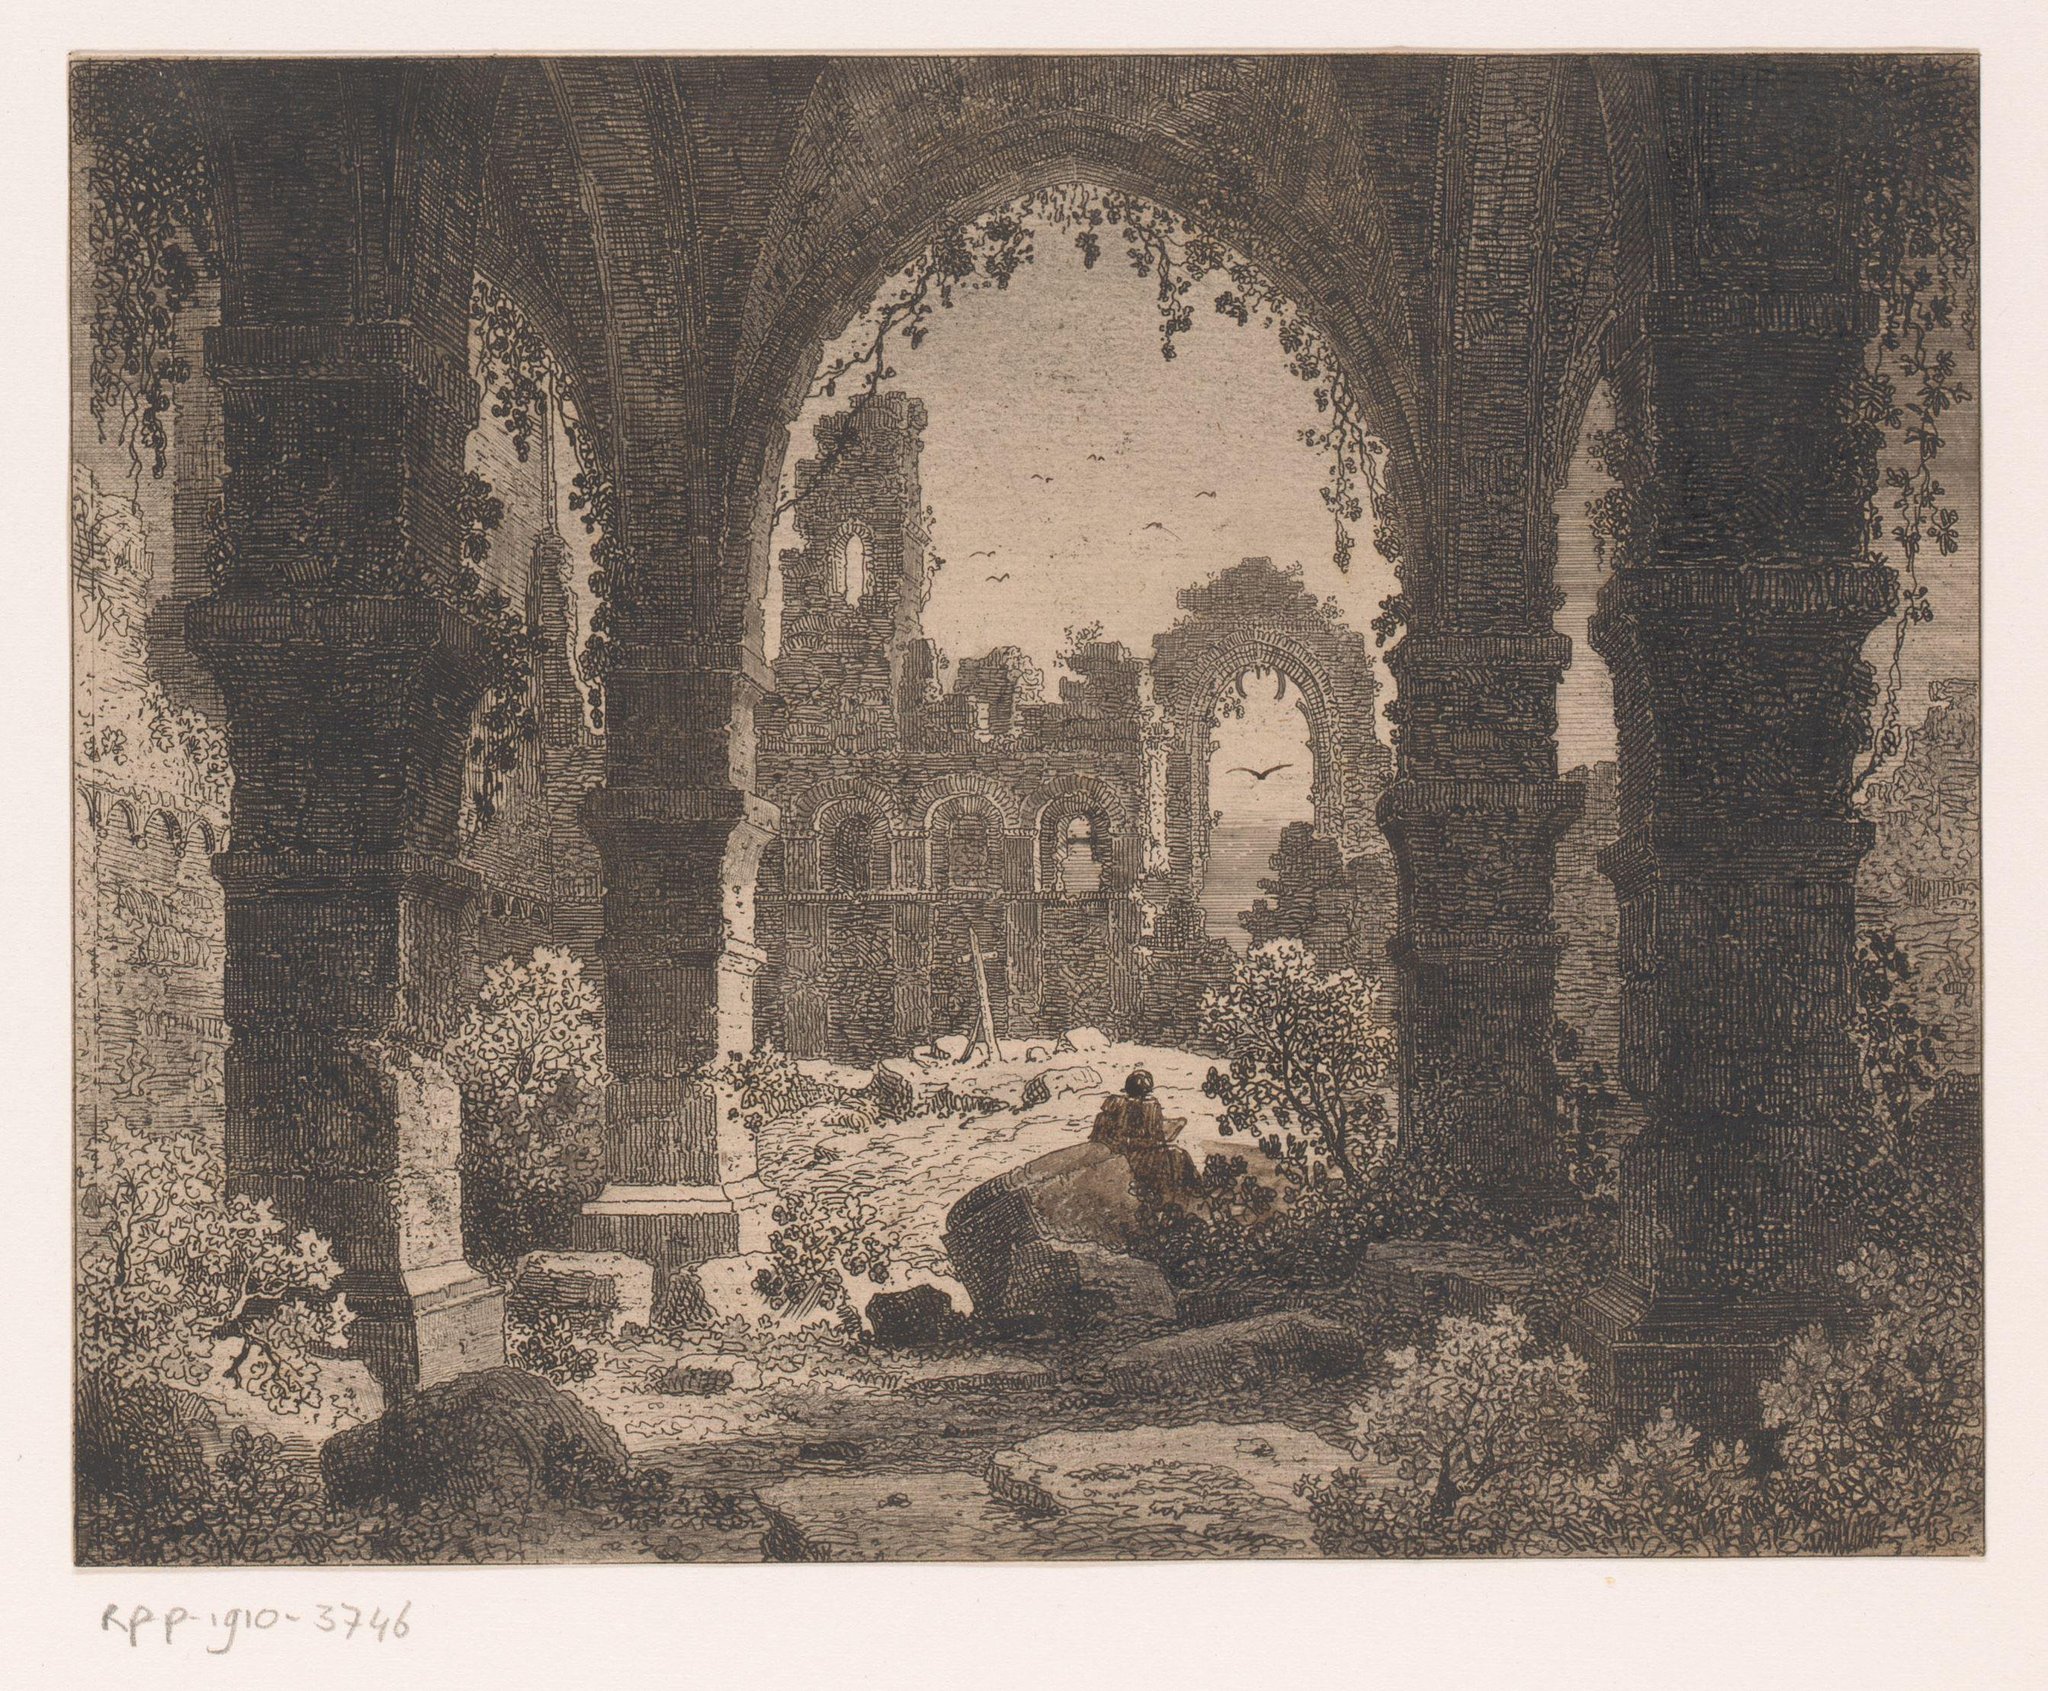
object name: print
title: Gezicht op de ruïne van kasteel Kenilworth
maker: guillaume van der hecht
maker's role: print maker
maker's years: 1817-1891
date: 1827-1879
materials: ink, paper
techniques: brush, etching, intaglio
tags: landscape with tower or castle, ruin of a dwelling, house, castle, etc.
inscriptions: collector's mark: Lugt 2228, collector's mark: Lugt 1485